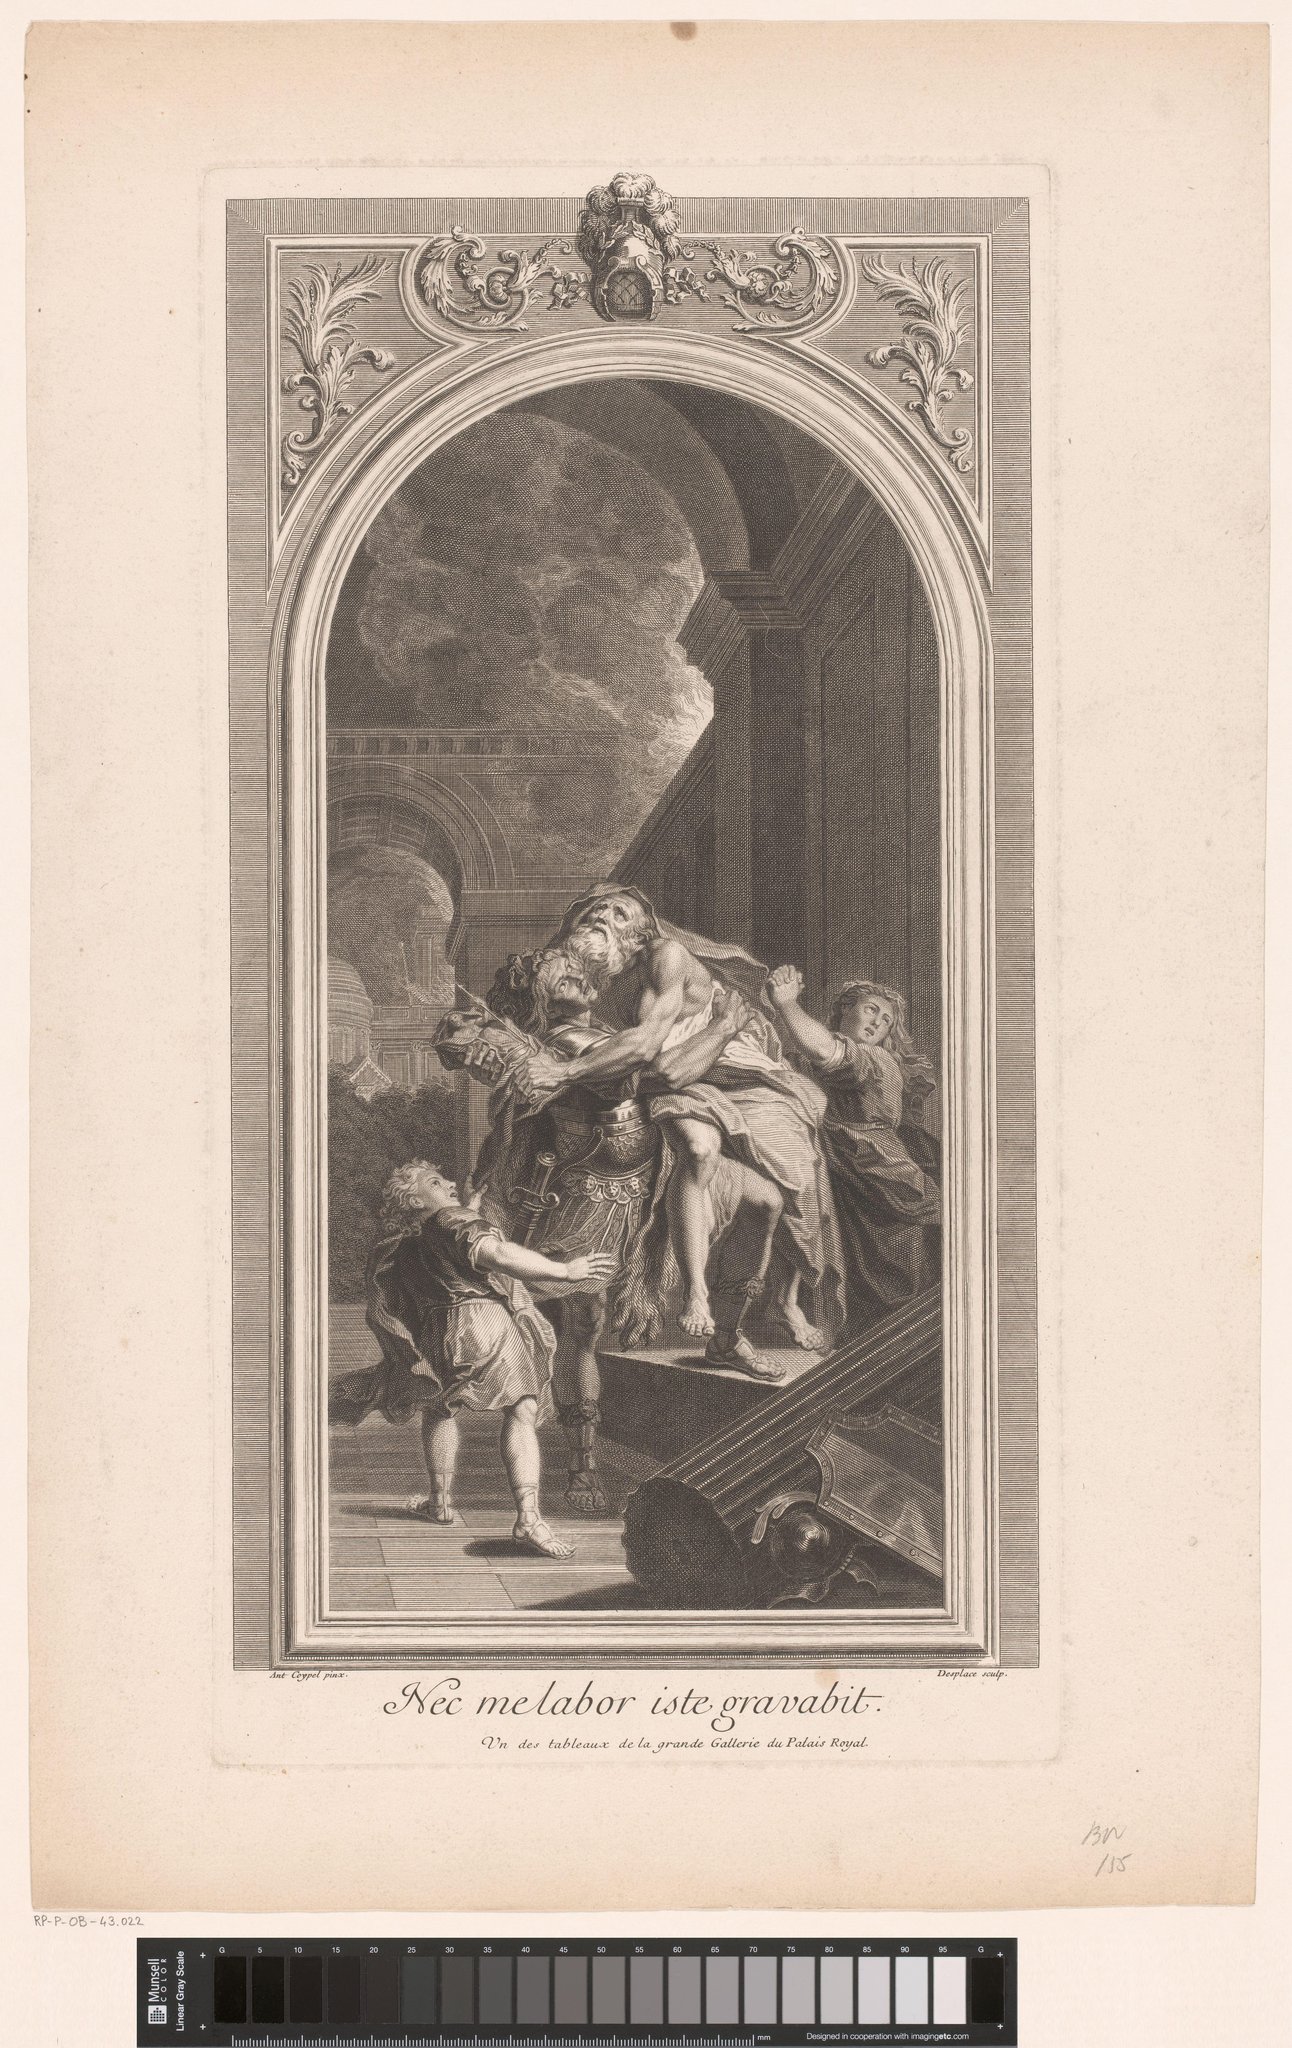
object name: print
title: Aeneas en zijn familie vluchten uit Troje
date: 1692-1739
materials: paper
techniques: engraving, etching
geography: paris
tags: 'pius aeneas': aeneas, leading ascanius, escapes from burning troy, carrying his father anchises with the penates; his wife creusa, who sets out with them, is lost on the way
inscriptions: collector's mark: Lugt 240